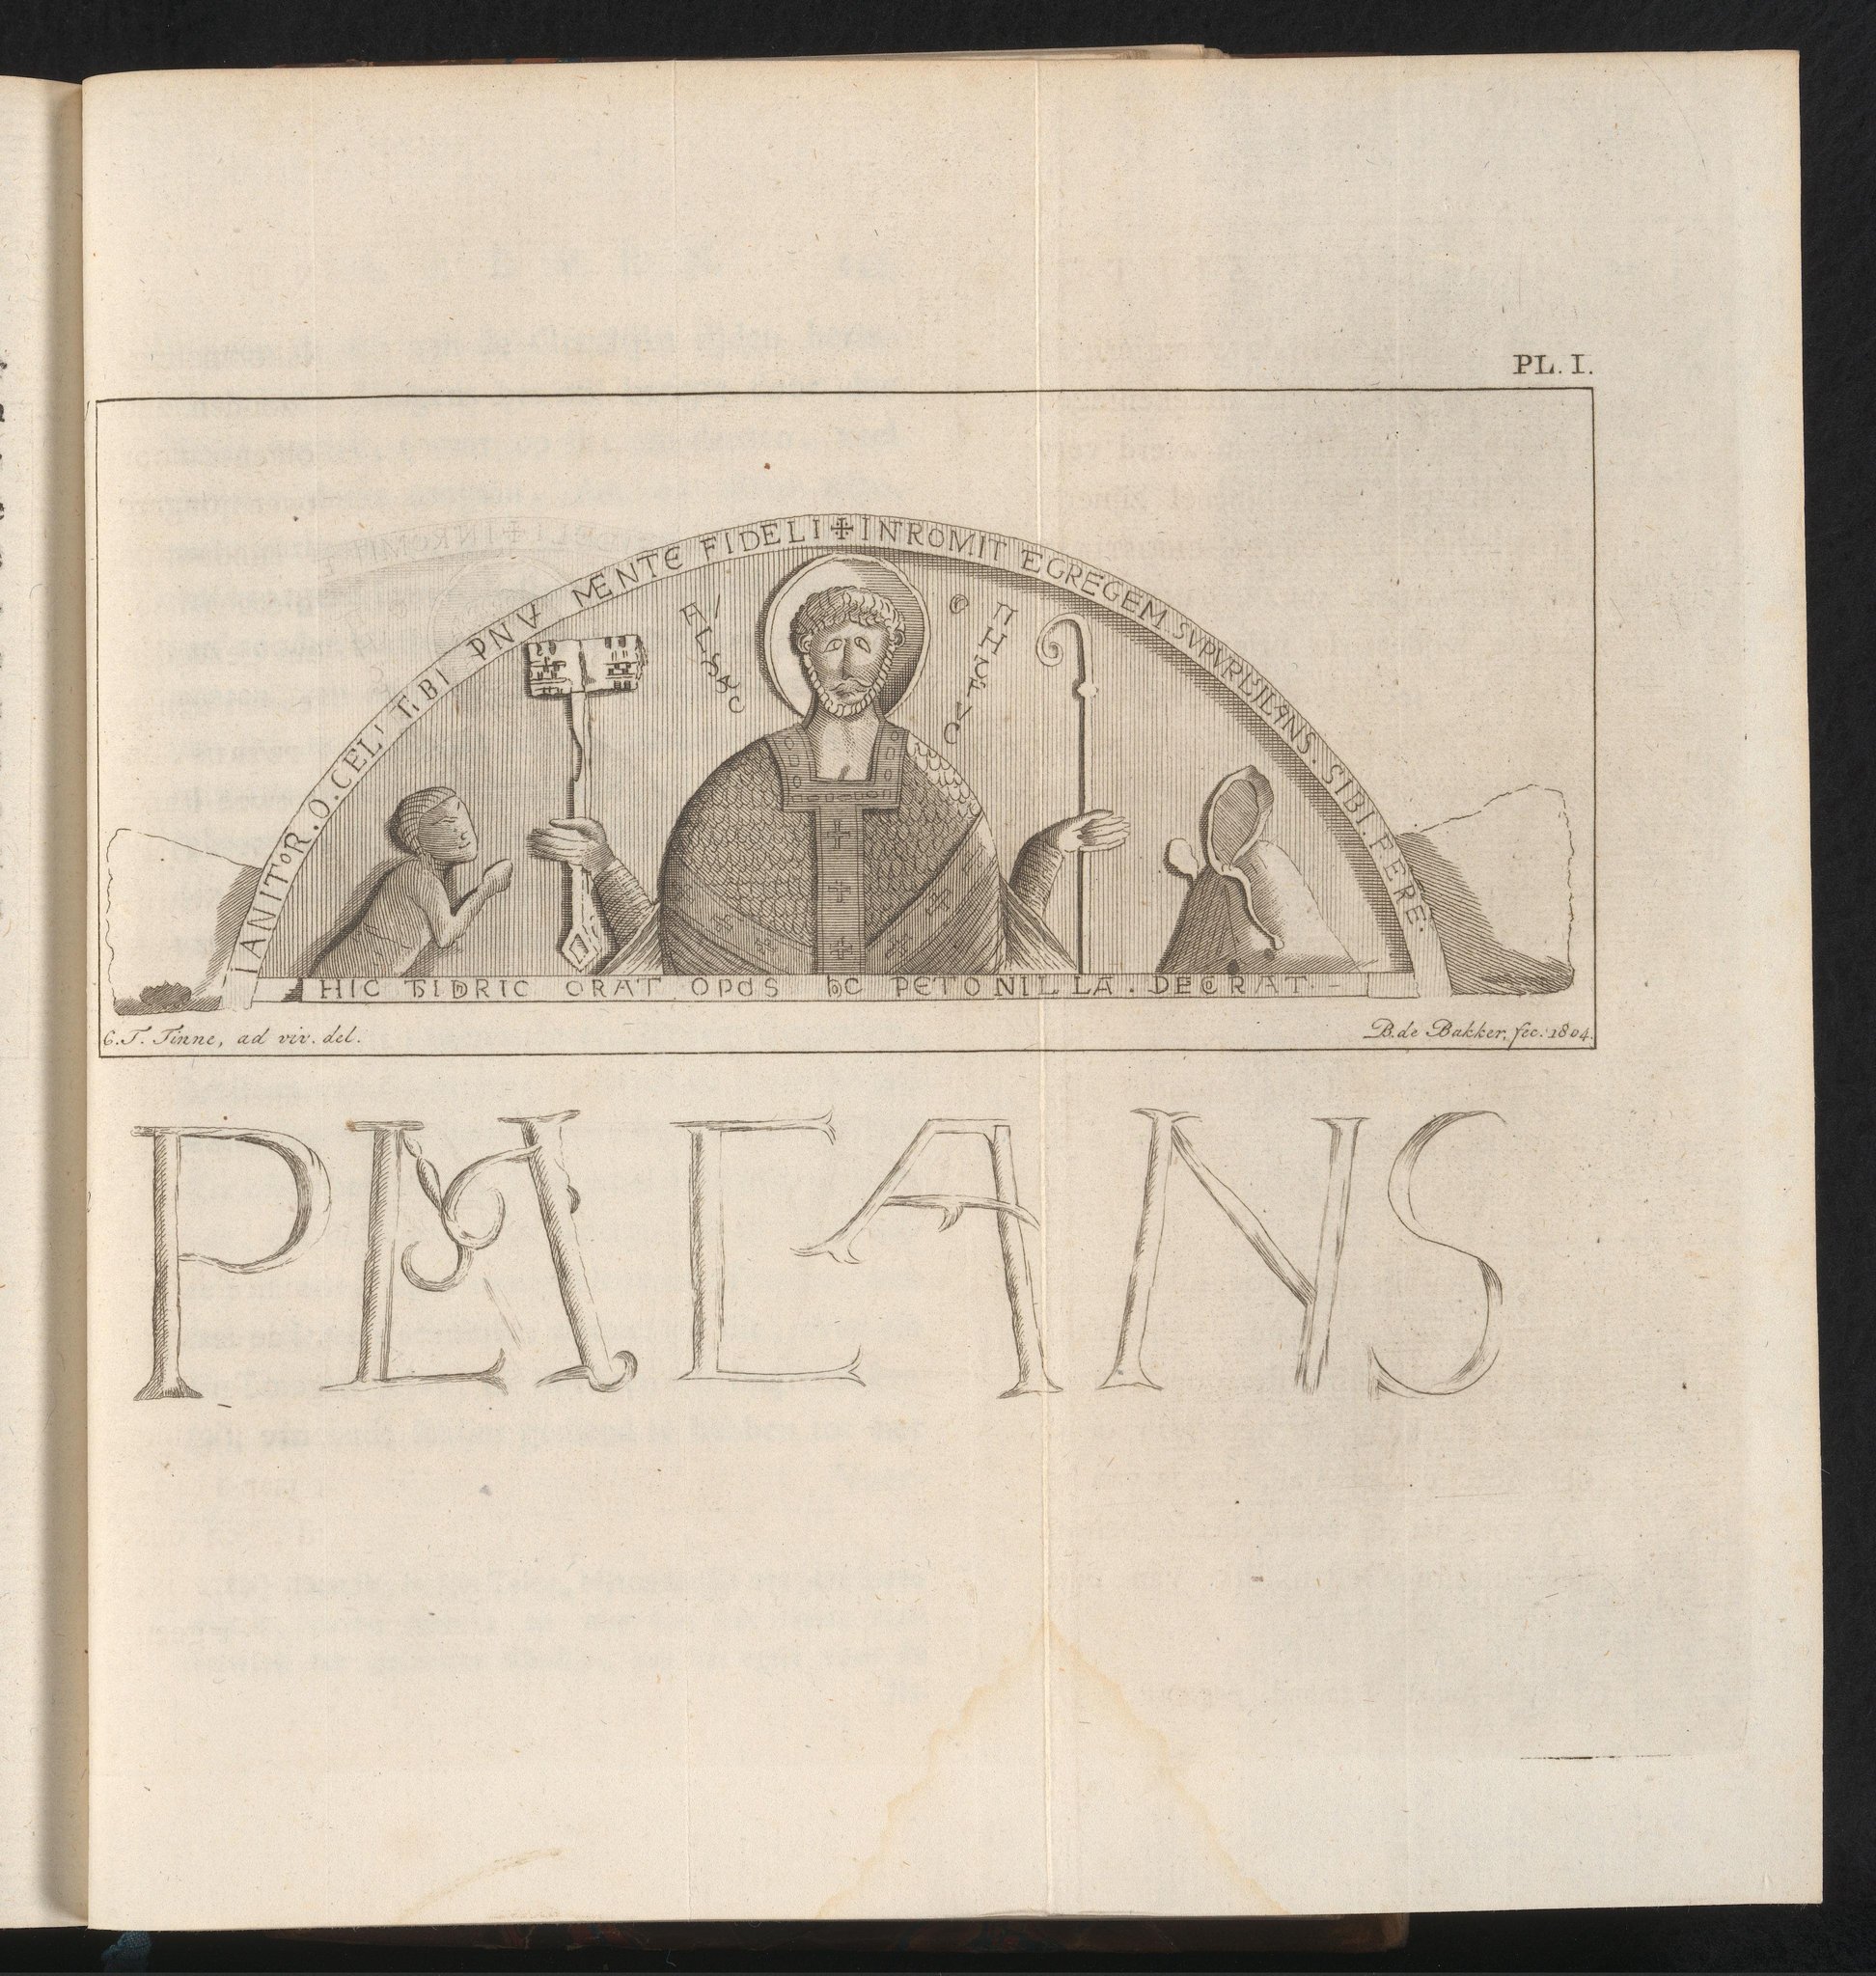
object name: print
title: Timpaan van Egmond: boogtrommel met Petrus, graaf Dirk VI van Holland en zijn moeder gravin Petronella, ca. 1120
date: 1804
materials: paper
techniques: etching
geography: netherlands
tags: piece of sculpture, reproduction of a piece of sculpture, art (+ relief ~ sculpture)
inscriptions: date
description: Timpaan van Egmond: boogtrommel met Petrus, graaf Dirk VI van Holland en zijn moeder gravin Petronella. Het geheel omringd met Latijnse inscripties. De steen is afkomstig uit de voormalige Benedictijner Abdij van St. Petrus en St. Adelbert te Egmond-Binnen. Onder de steen enkele oude letters. Muller plaatst de voorstellingen van deze steen in het jaar 1009, in werkelijkheid is de steen vervaardigd ca. 1120.